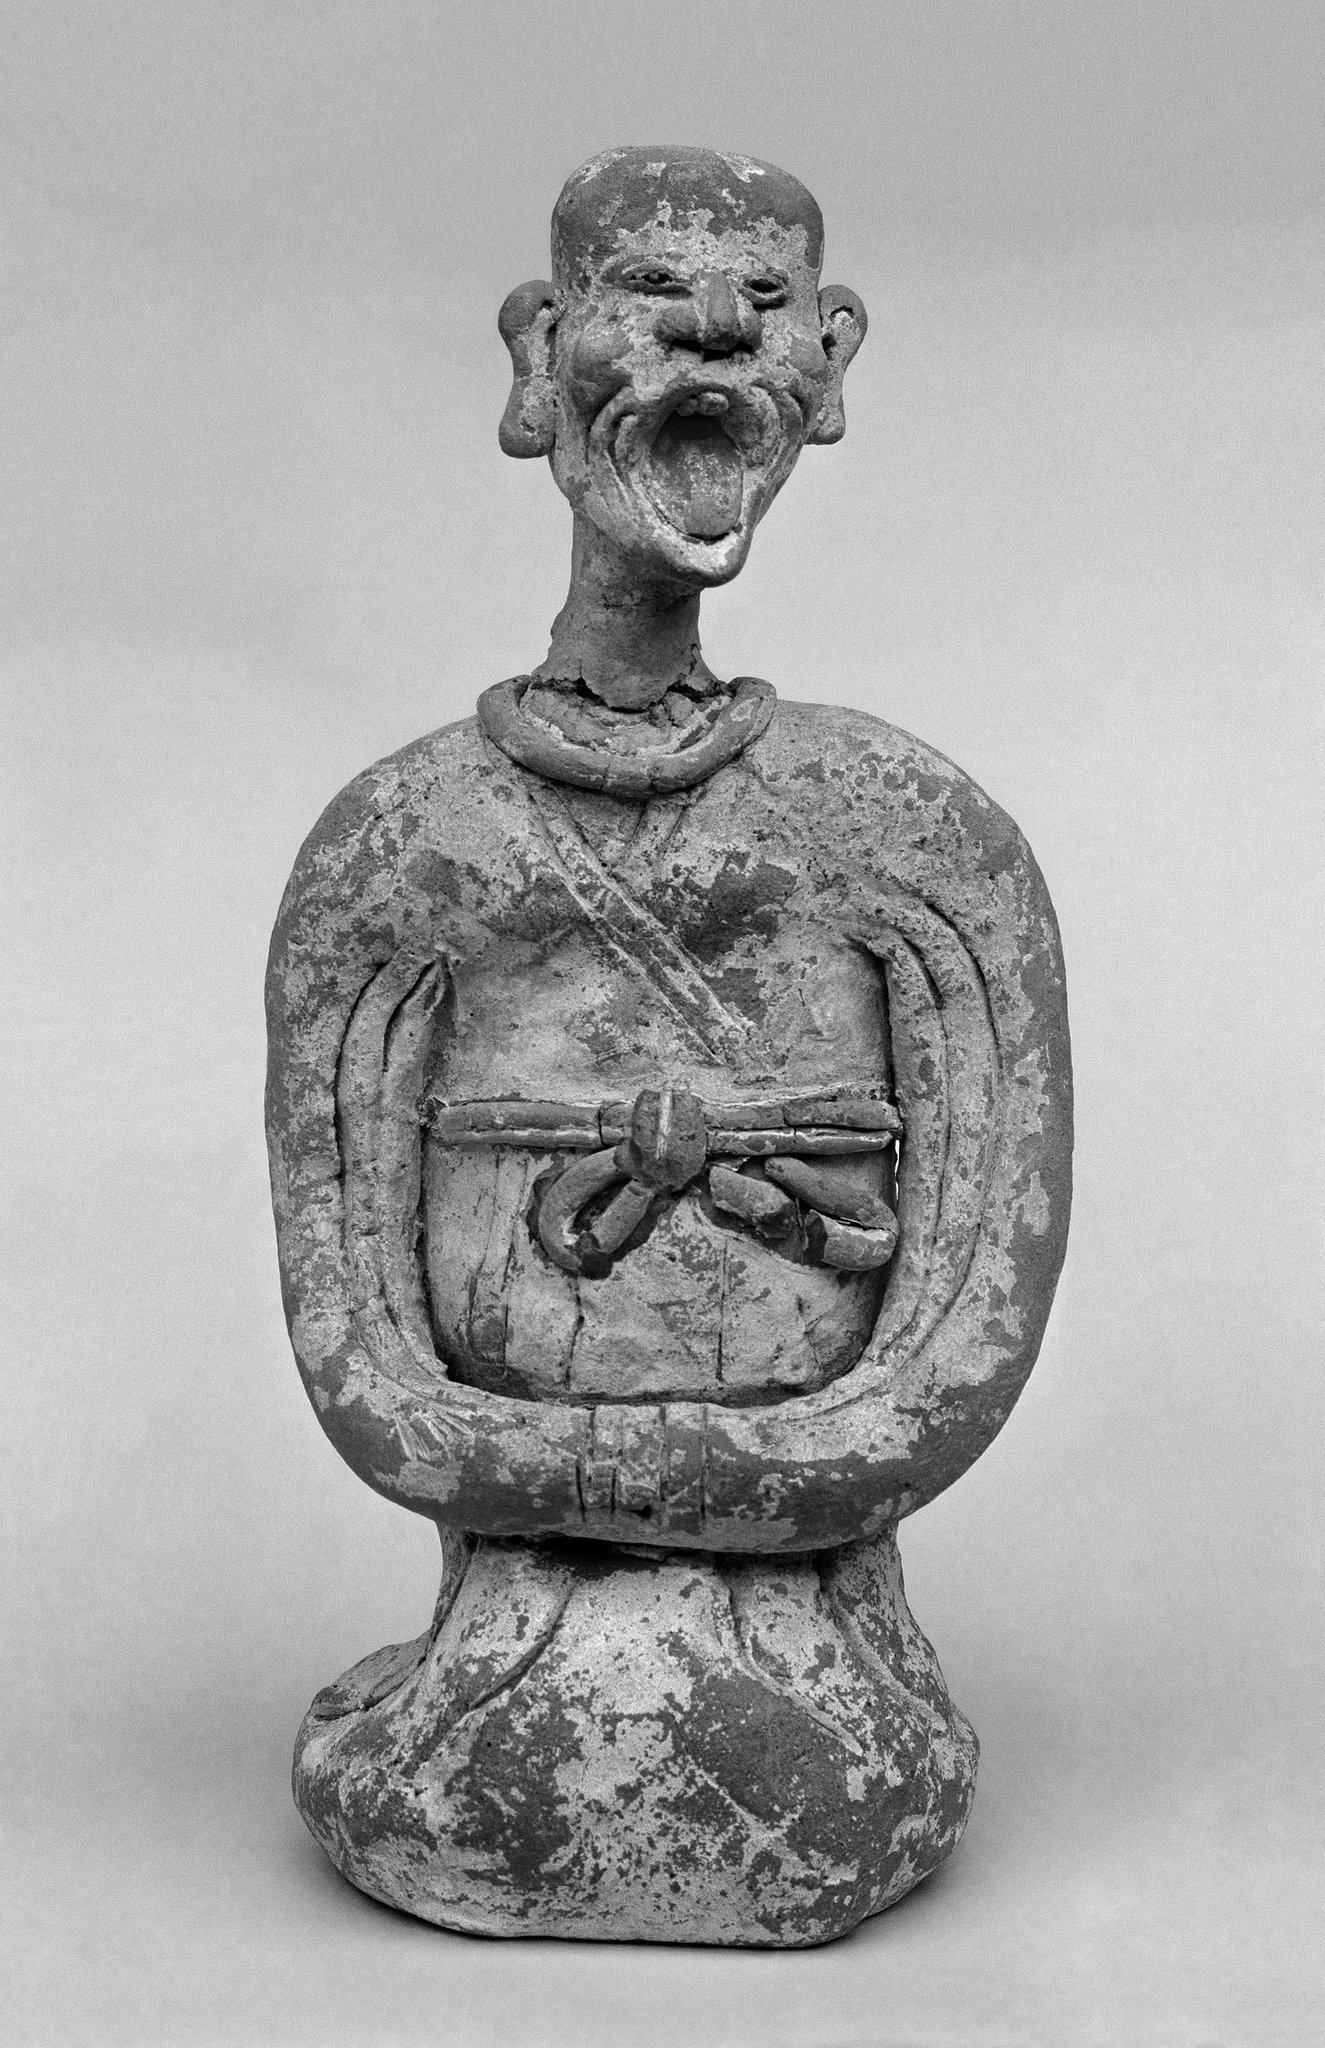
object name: figure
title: Luohan?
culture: chinese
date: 618-907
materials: mud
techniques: polychrome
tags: men